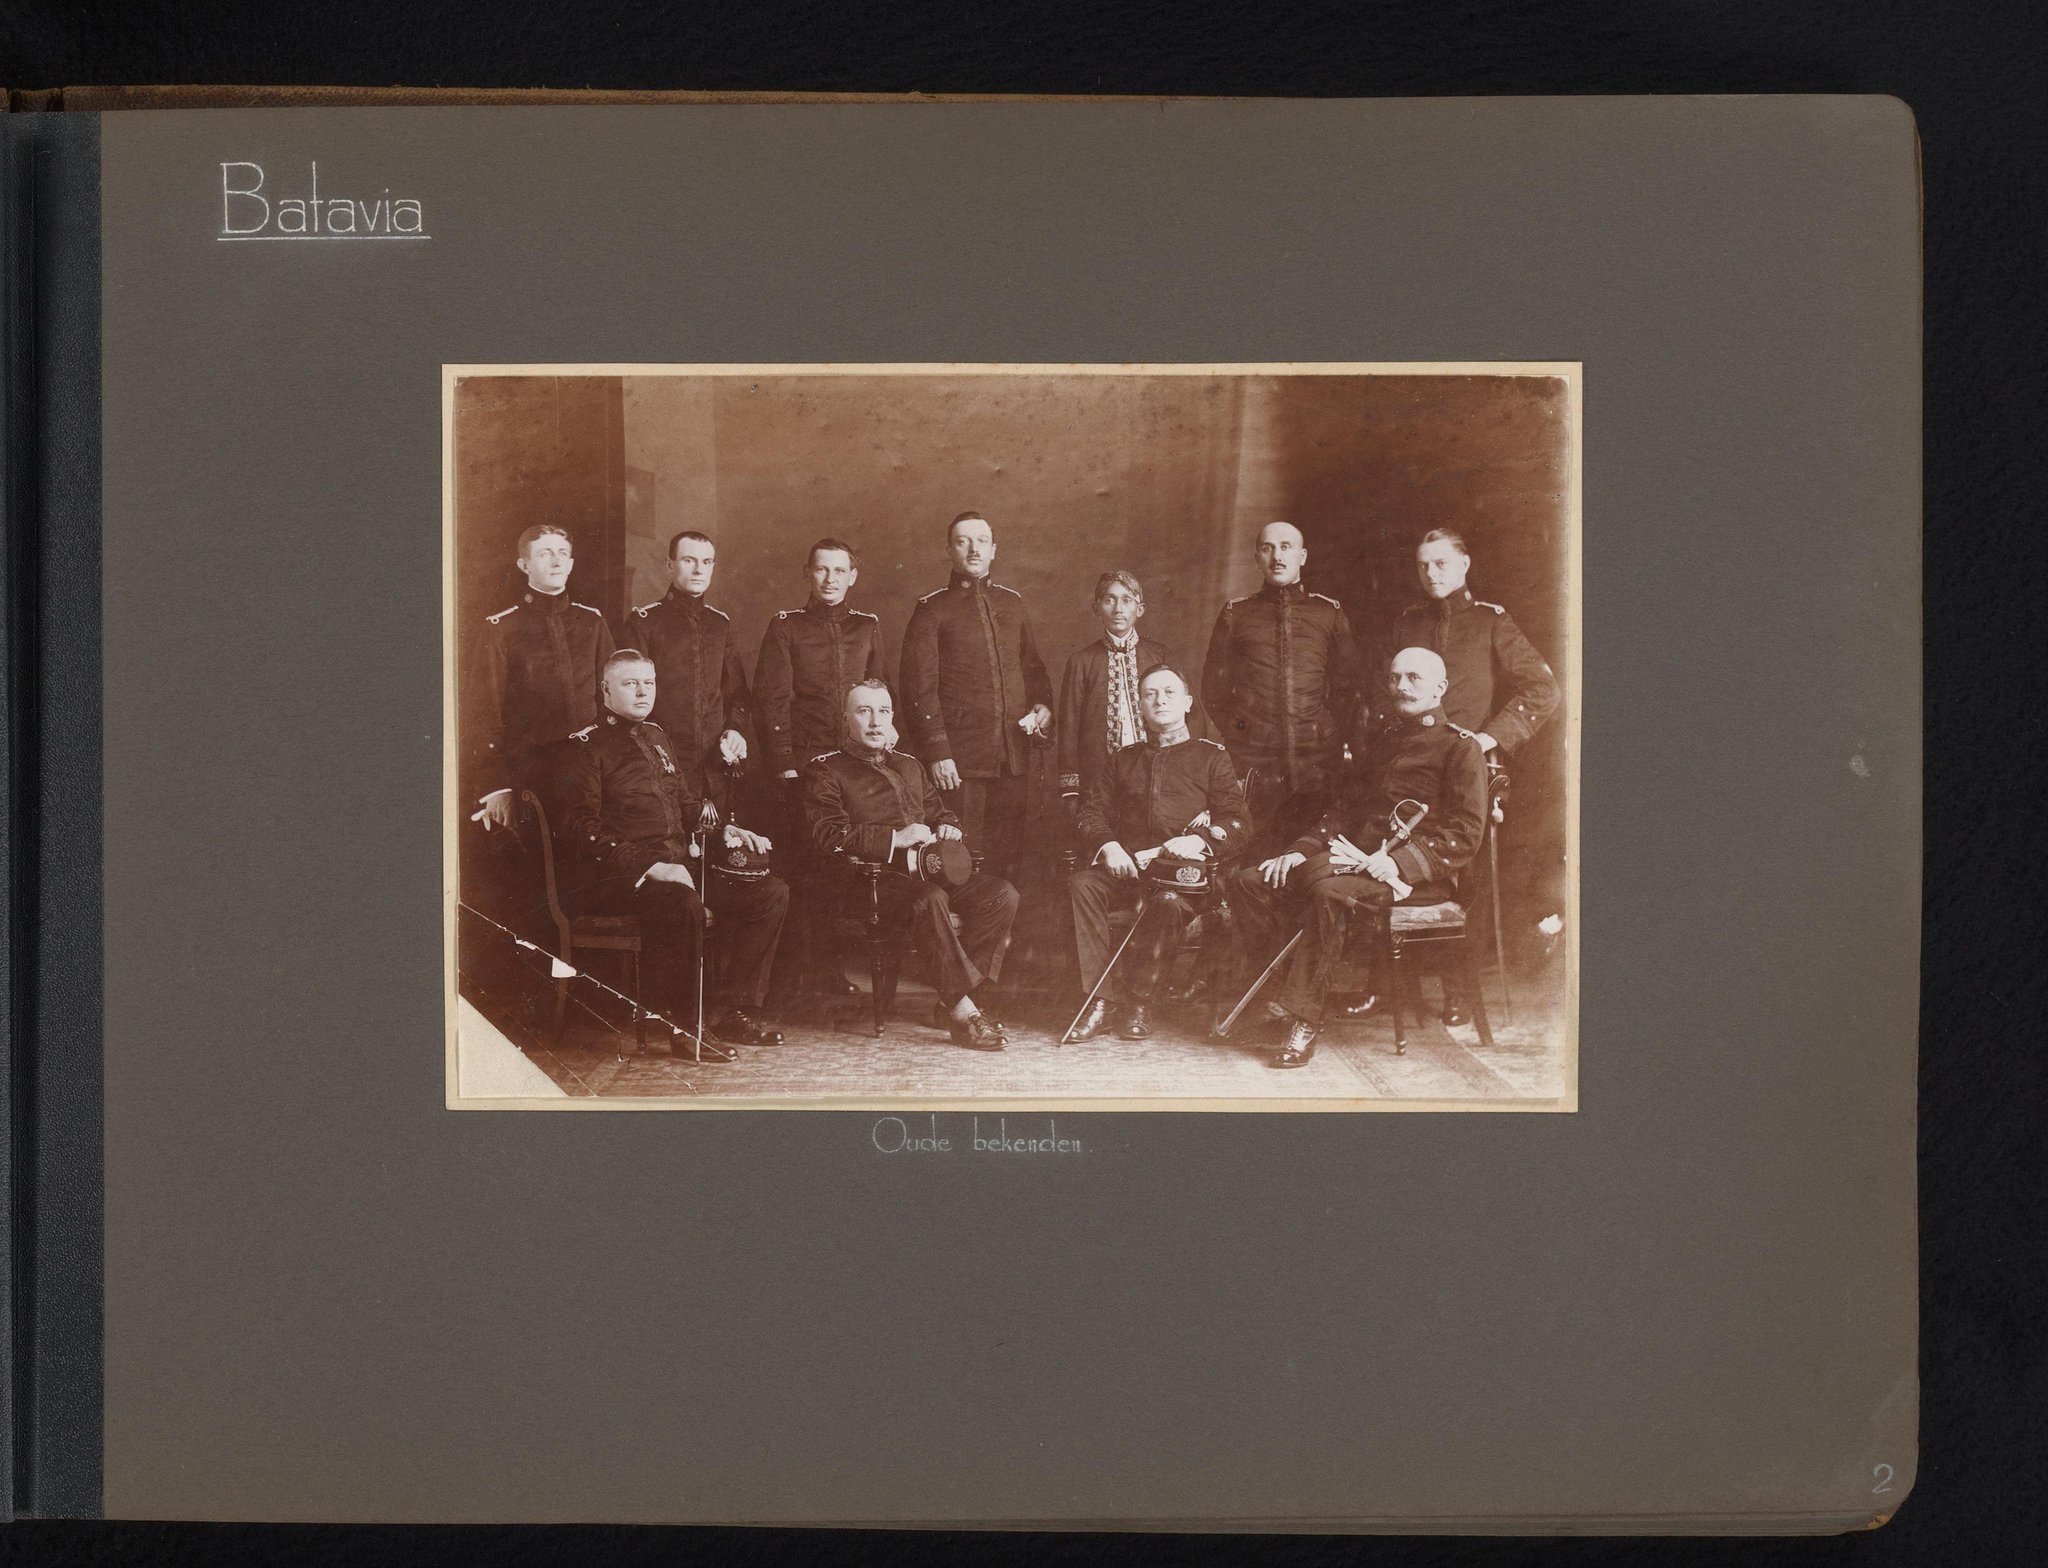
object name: photograph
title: Batavia / Oude bekenden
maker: Anonymous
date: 1925-1931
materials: cardboard, photographic support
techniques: collodion silver print, gelatin silver print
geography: batavia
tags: dutch east indies, the, batavia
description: Albumblad met één foto: groepsportret van Europese mannen, waarschijnlijk leden van de Vereeniging van Hoogere Politie Ambtenaren in Nederlandsch-Indië, in Batavia. Onderdeel van het fotoalbum aangeboden aan S. Koster door de Vereeniging van Hoogere Politie Ambtenaren in Nederlandsch-Indië in 1931.